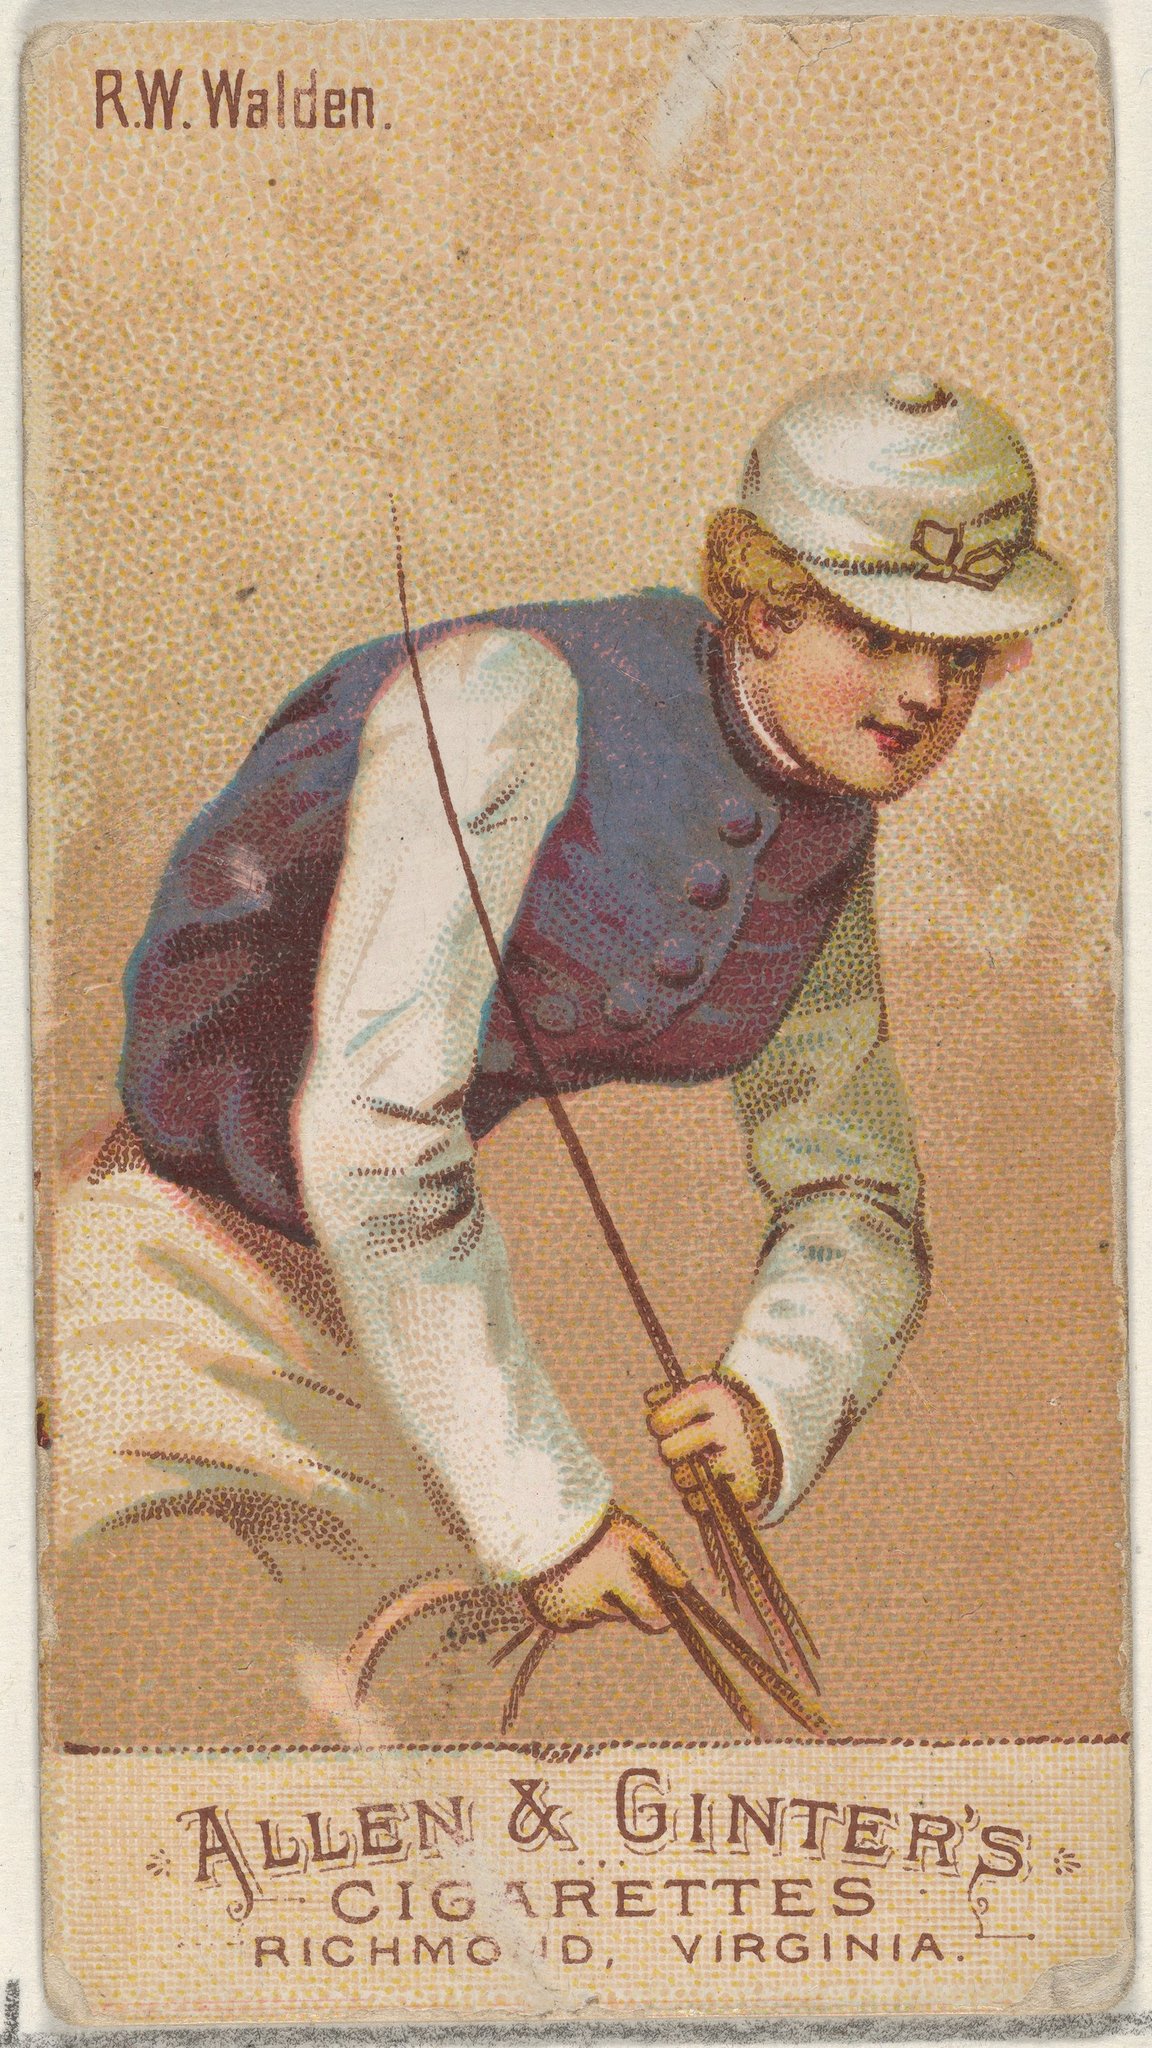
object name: print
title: R.W. Walden, from the Racing Colors of the World series (N22b) for Allen & Ginter Cigarettes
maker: allen & ginter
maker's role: publisher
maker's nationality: american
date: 1888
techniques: color lithograph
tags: women,jockeys